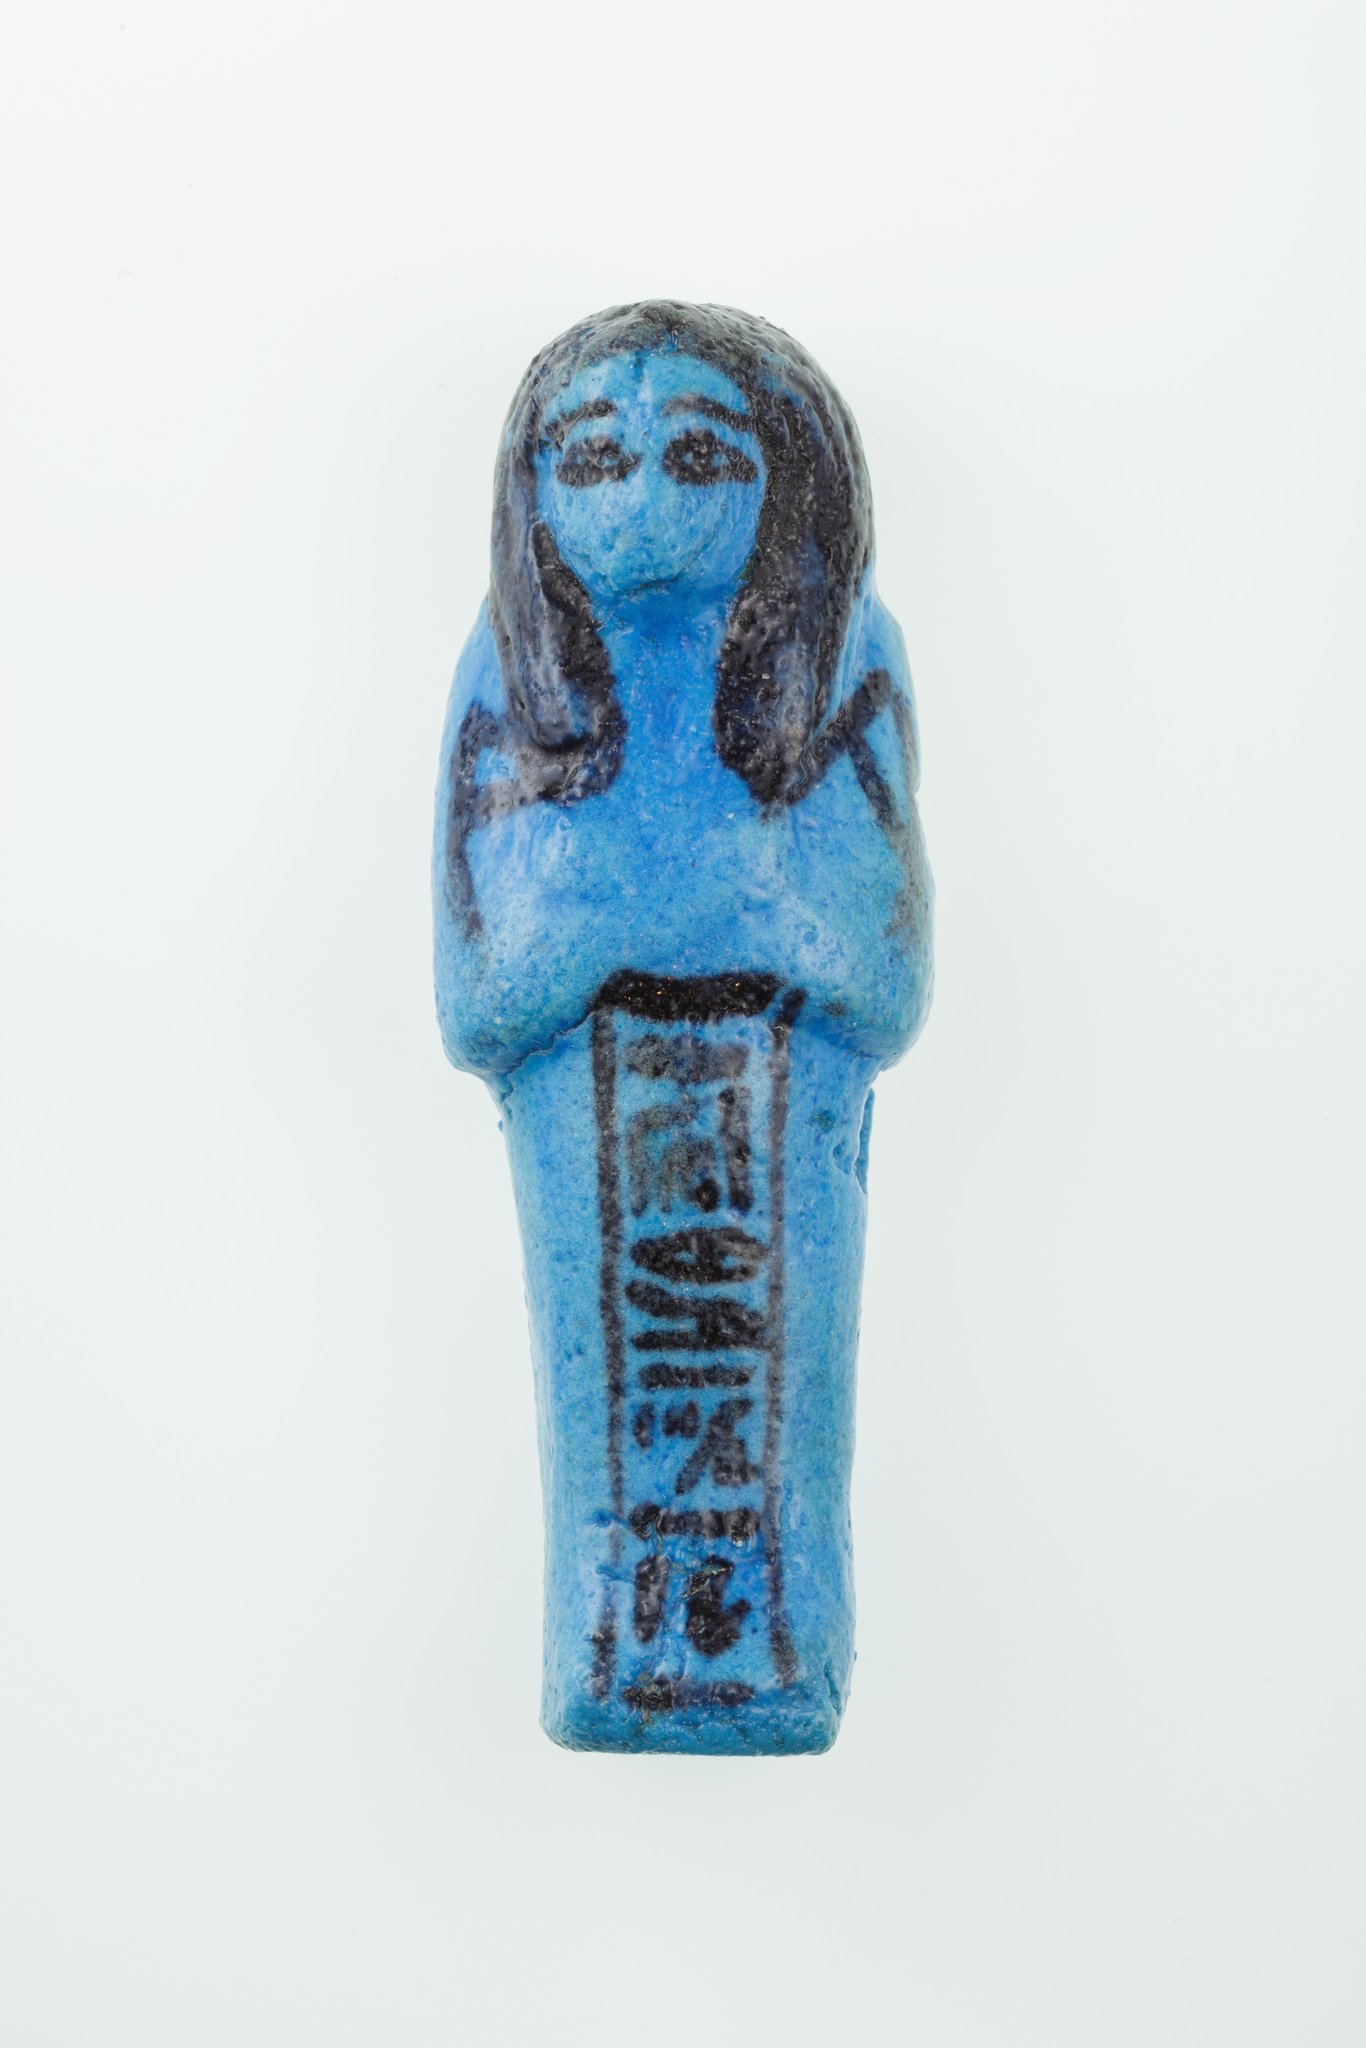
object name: shabti, worker, nauny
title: Worker Shabti of Nauny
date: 1050 BCE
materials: faience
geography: egypt